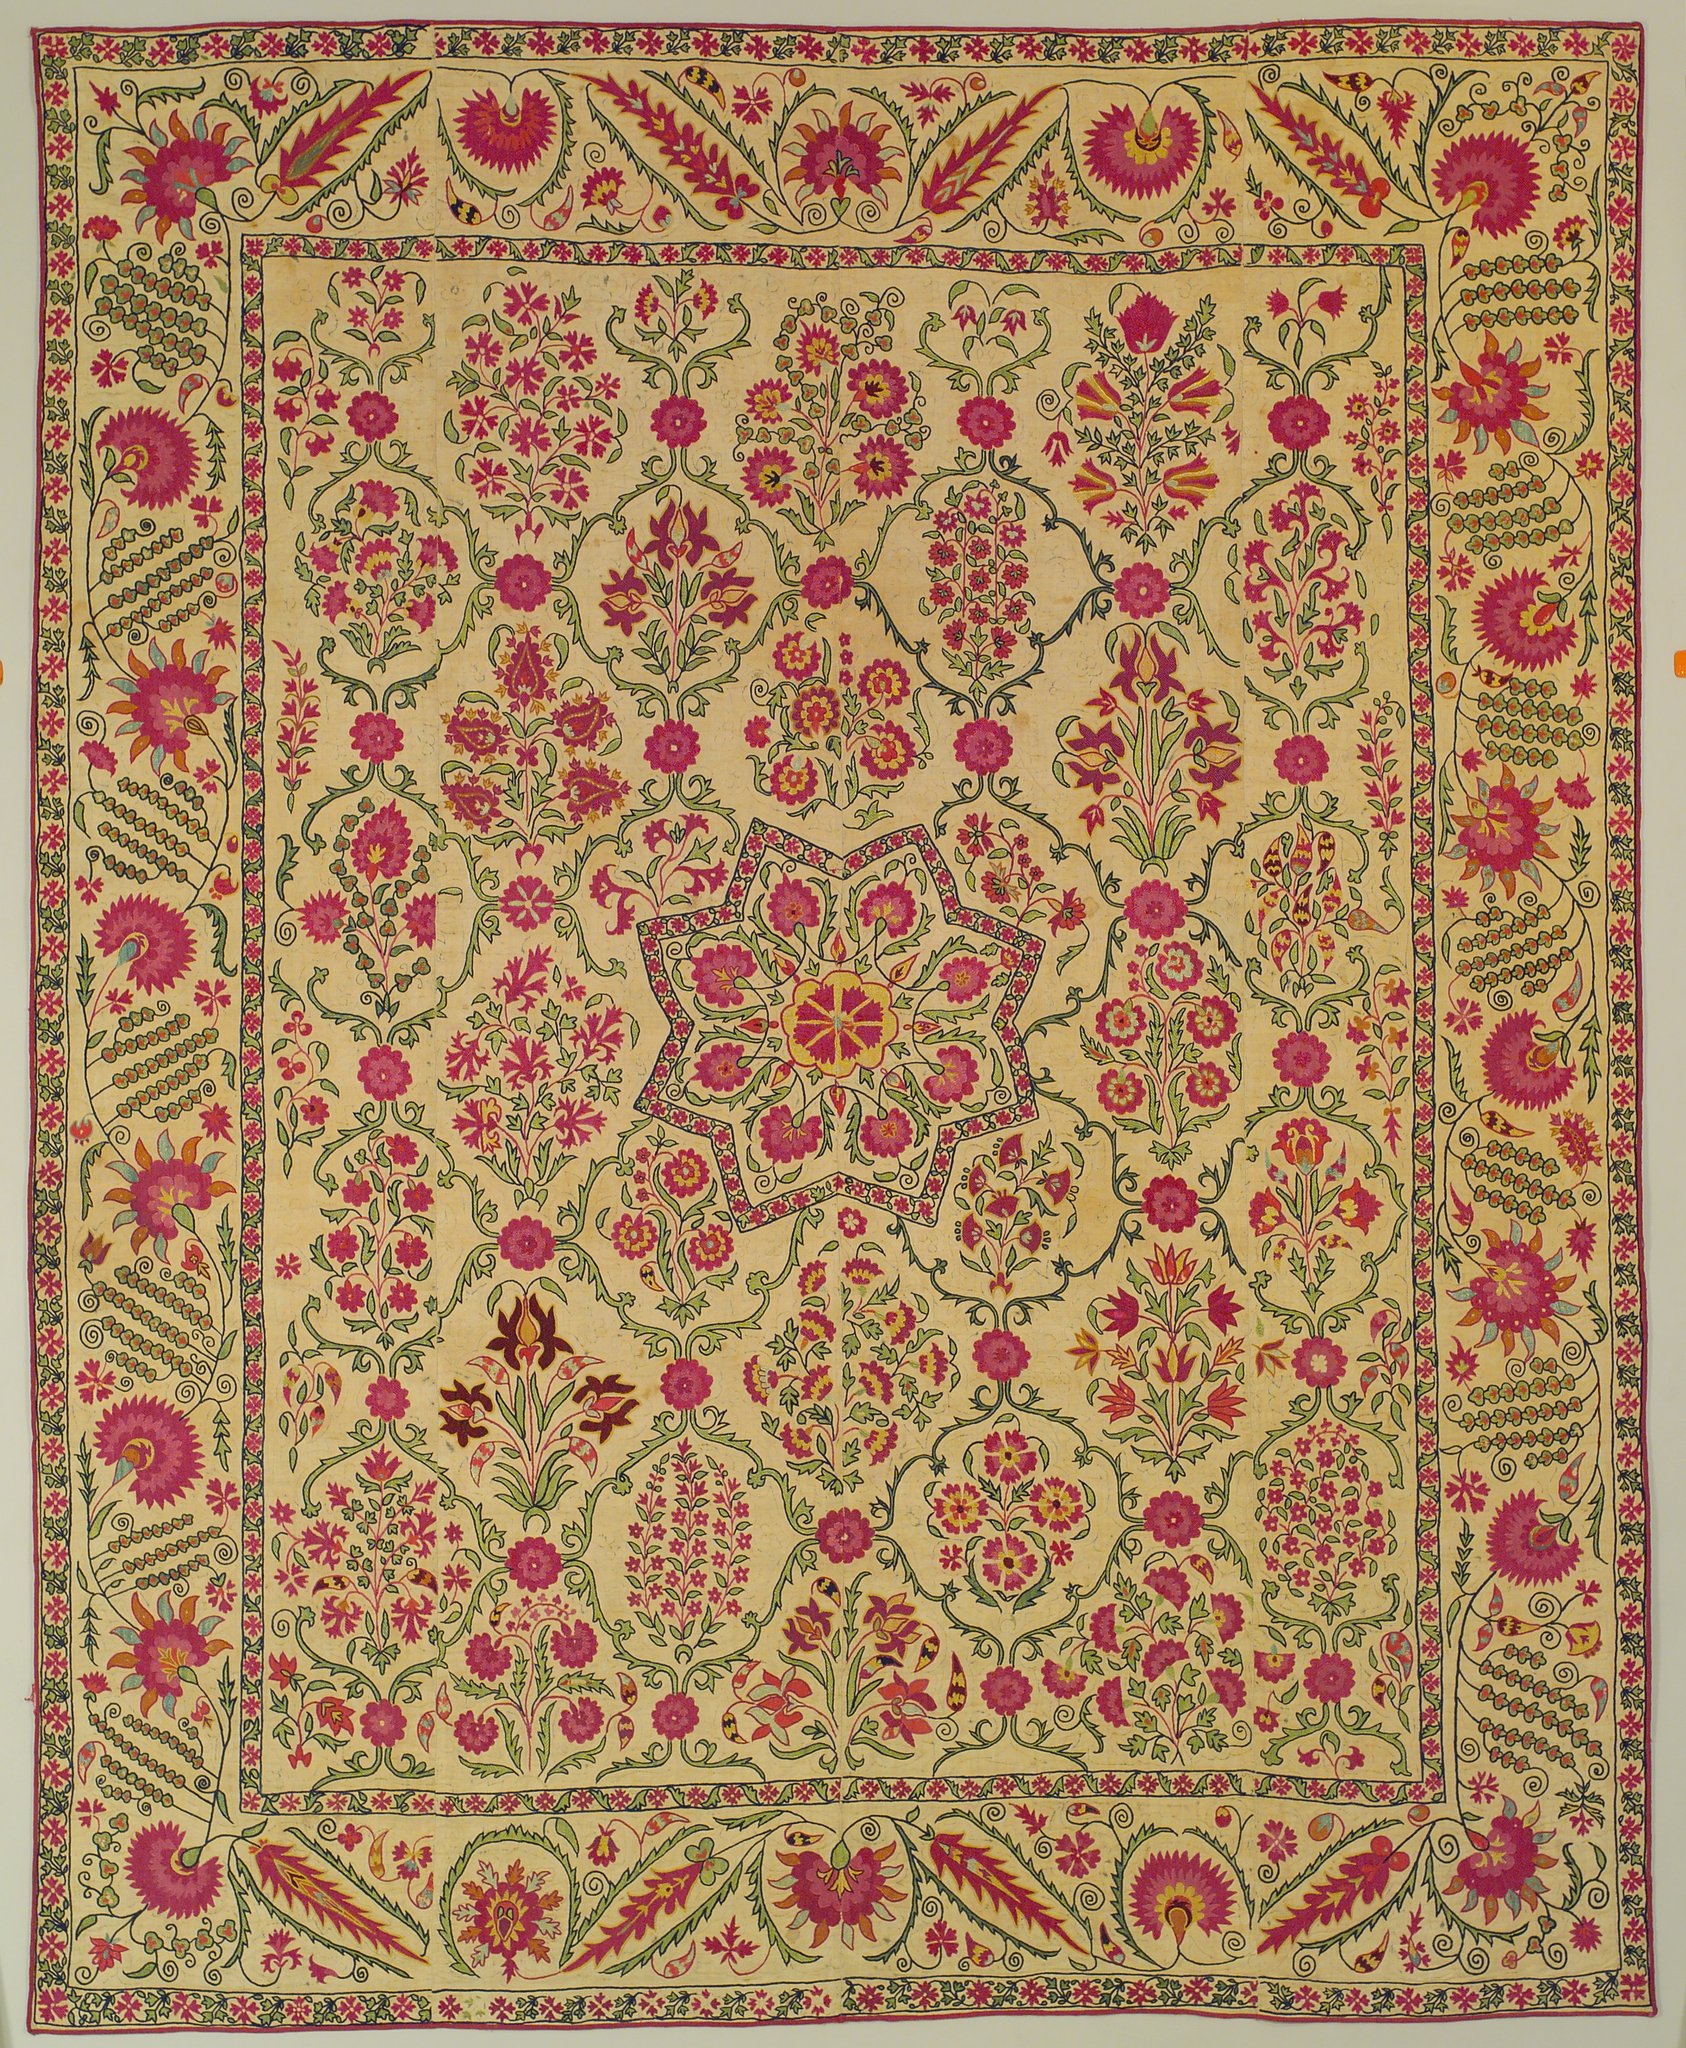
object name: hanging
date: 1801-1833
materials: cotton, textile, silk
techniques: embroidery, stitching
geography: uzbekistan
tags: flowers